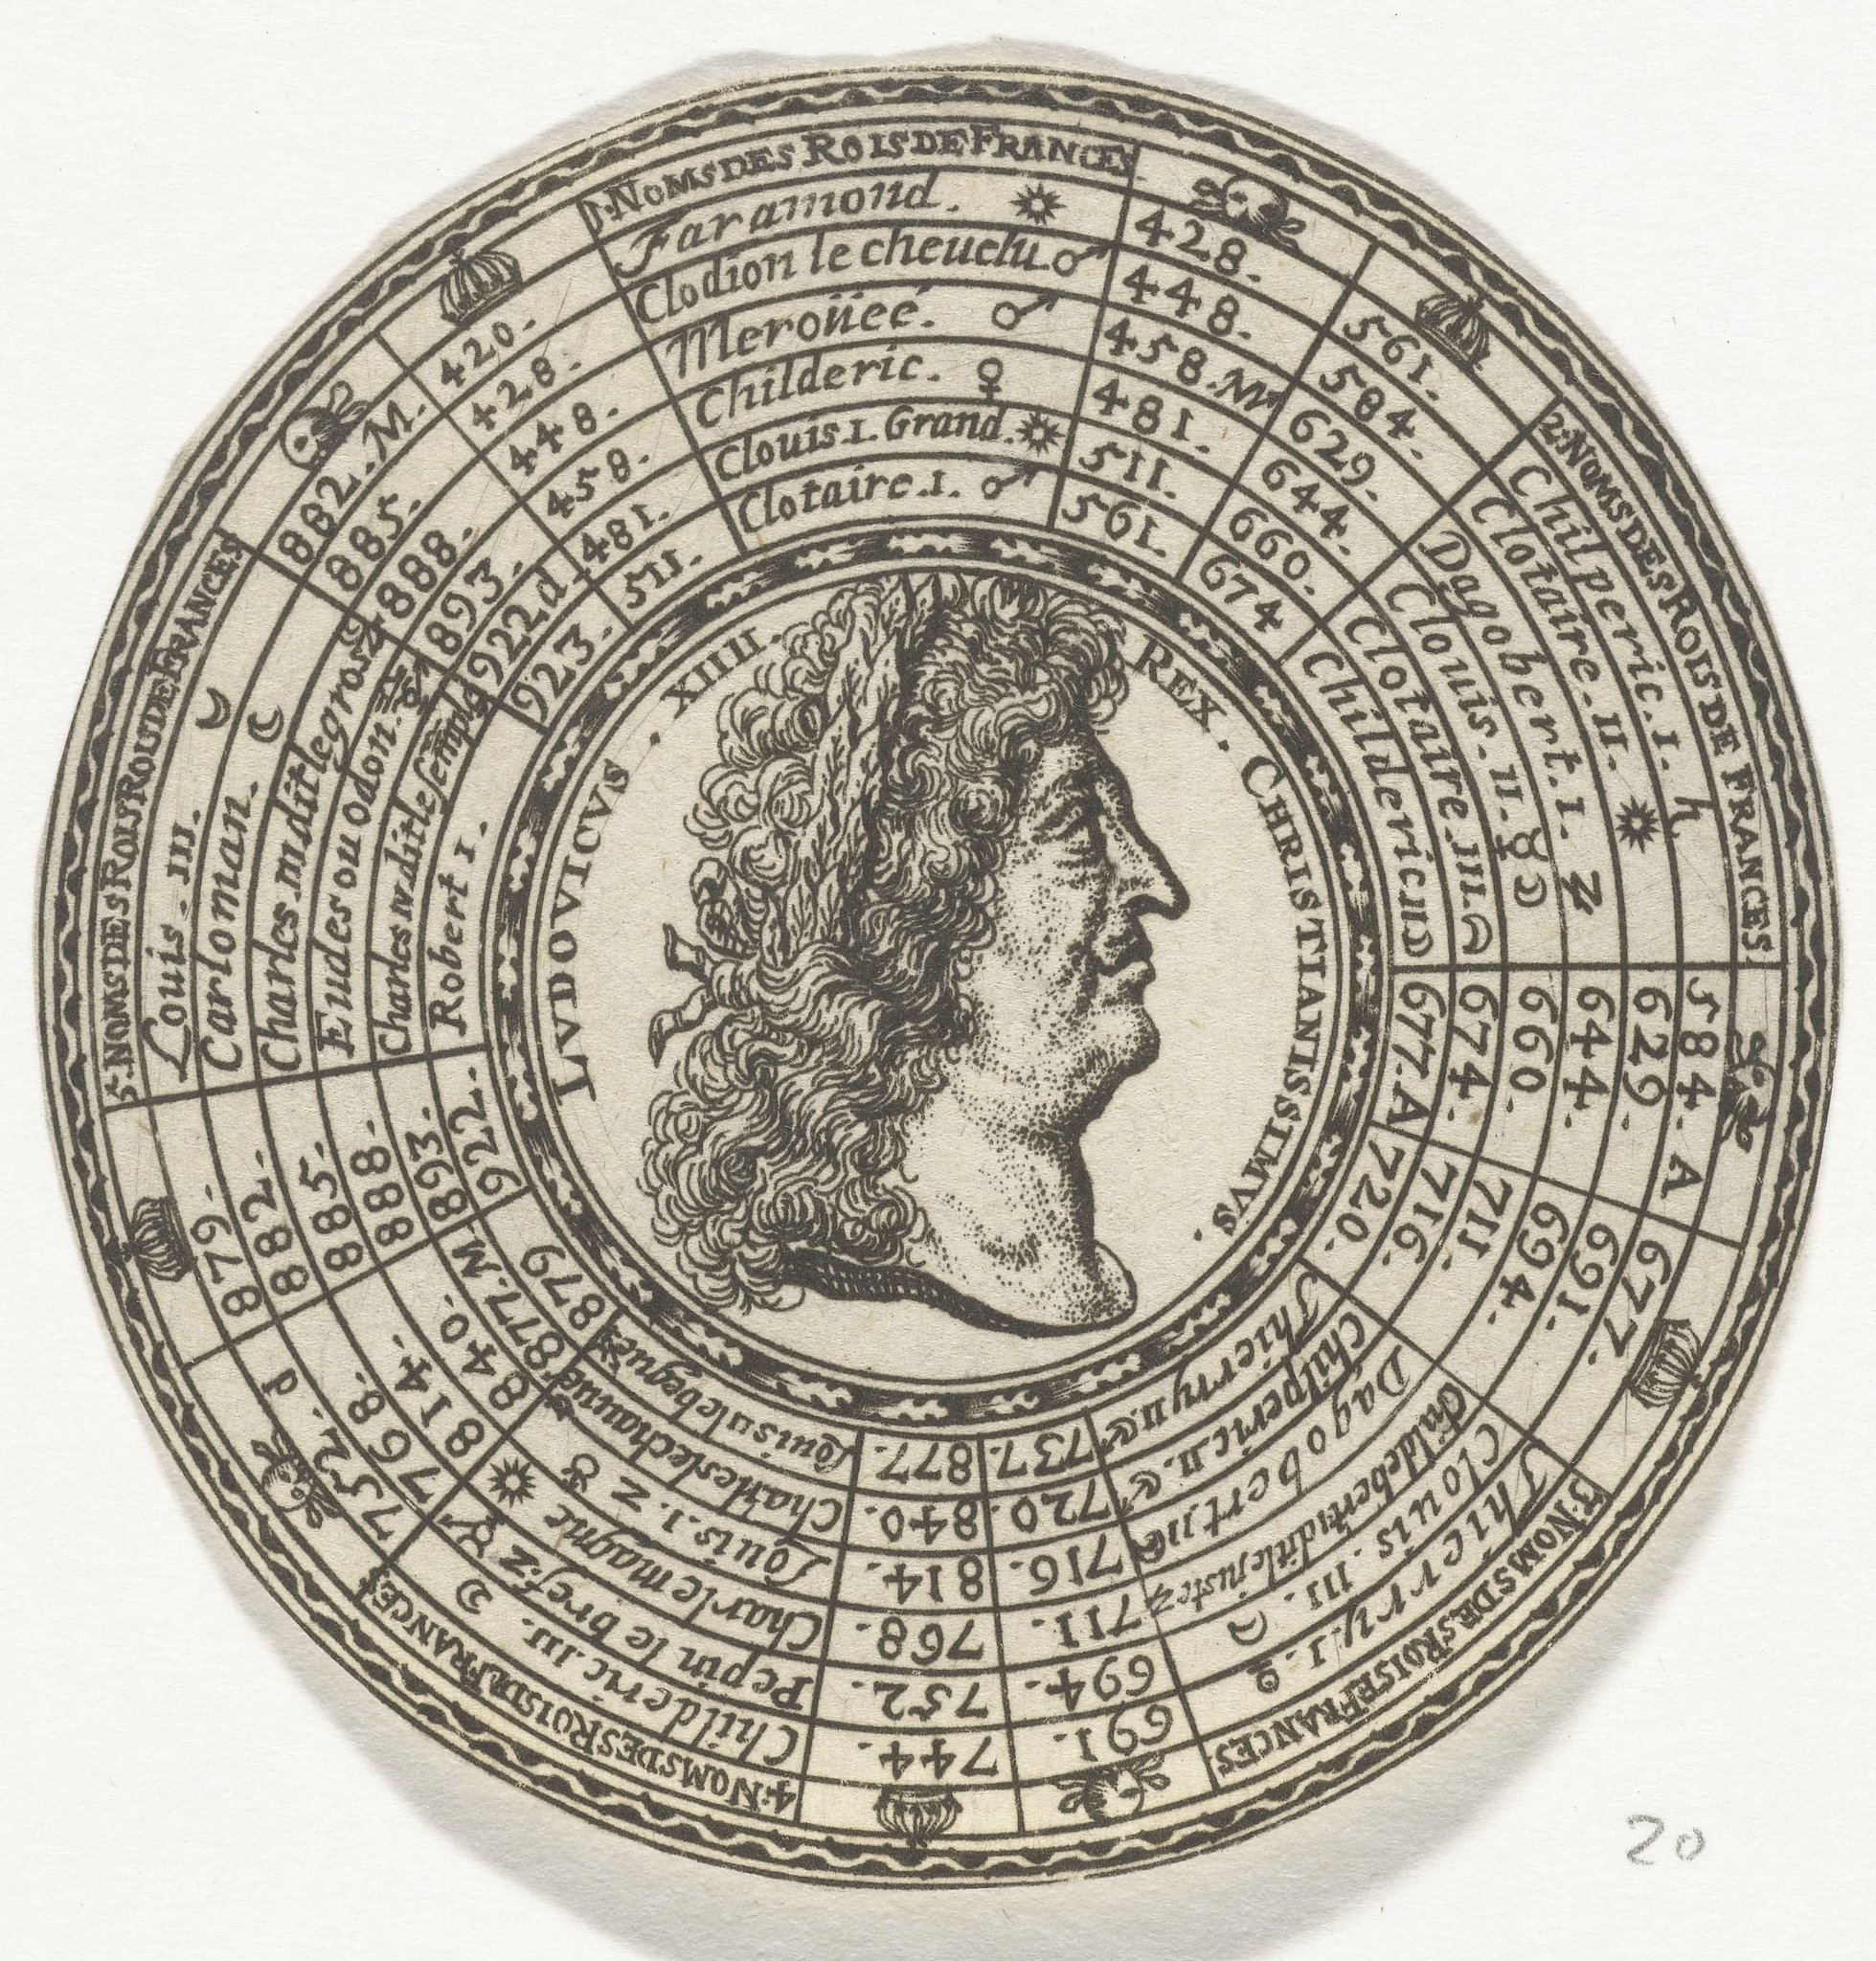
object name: print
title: Penning met het portret van koning Lodewijk XIV en de namen van Franse koningen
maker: Anonymous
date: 1712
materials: paper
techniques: etching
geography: amsterdam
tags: lodewijk xiv (koning van frankrijk), king, seal (symbol of sovereignty)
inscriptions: number: ‘21’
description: Ontwerp van een ronde penning met, in zeven concentrische cirkels, de namen van Franse koningen en hun regeringsjaren, beginnende bij koning Pharamond en eindigend bij koning Robert I. In het midden van de penning het portret van Lodewijk XIV.